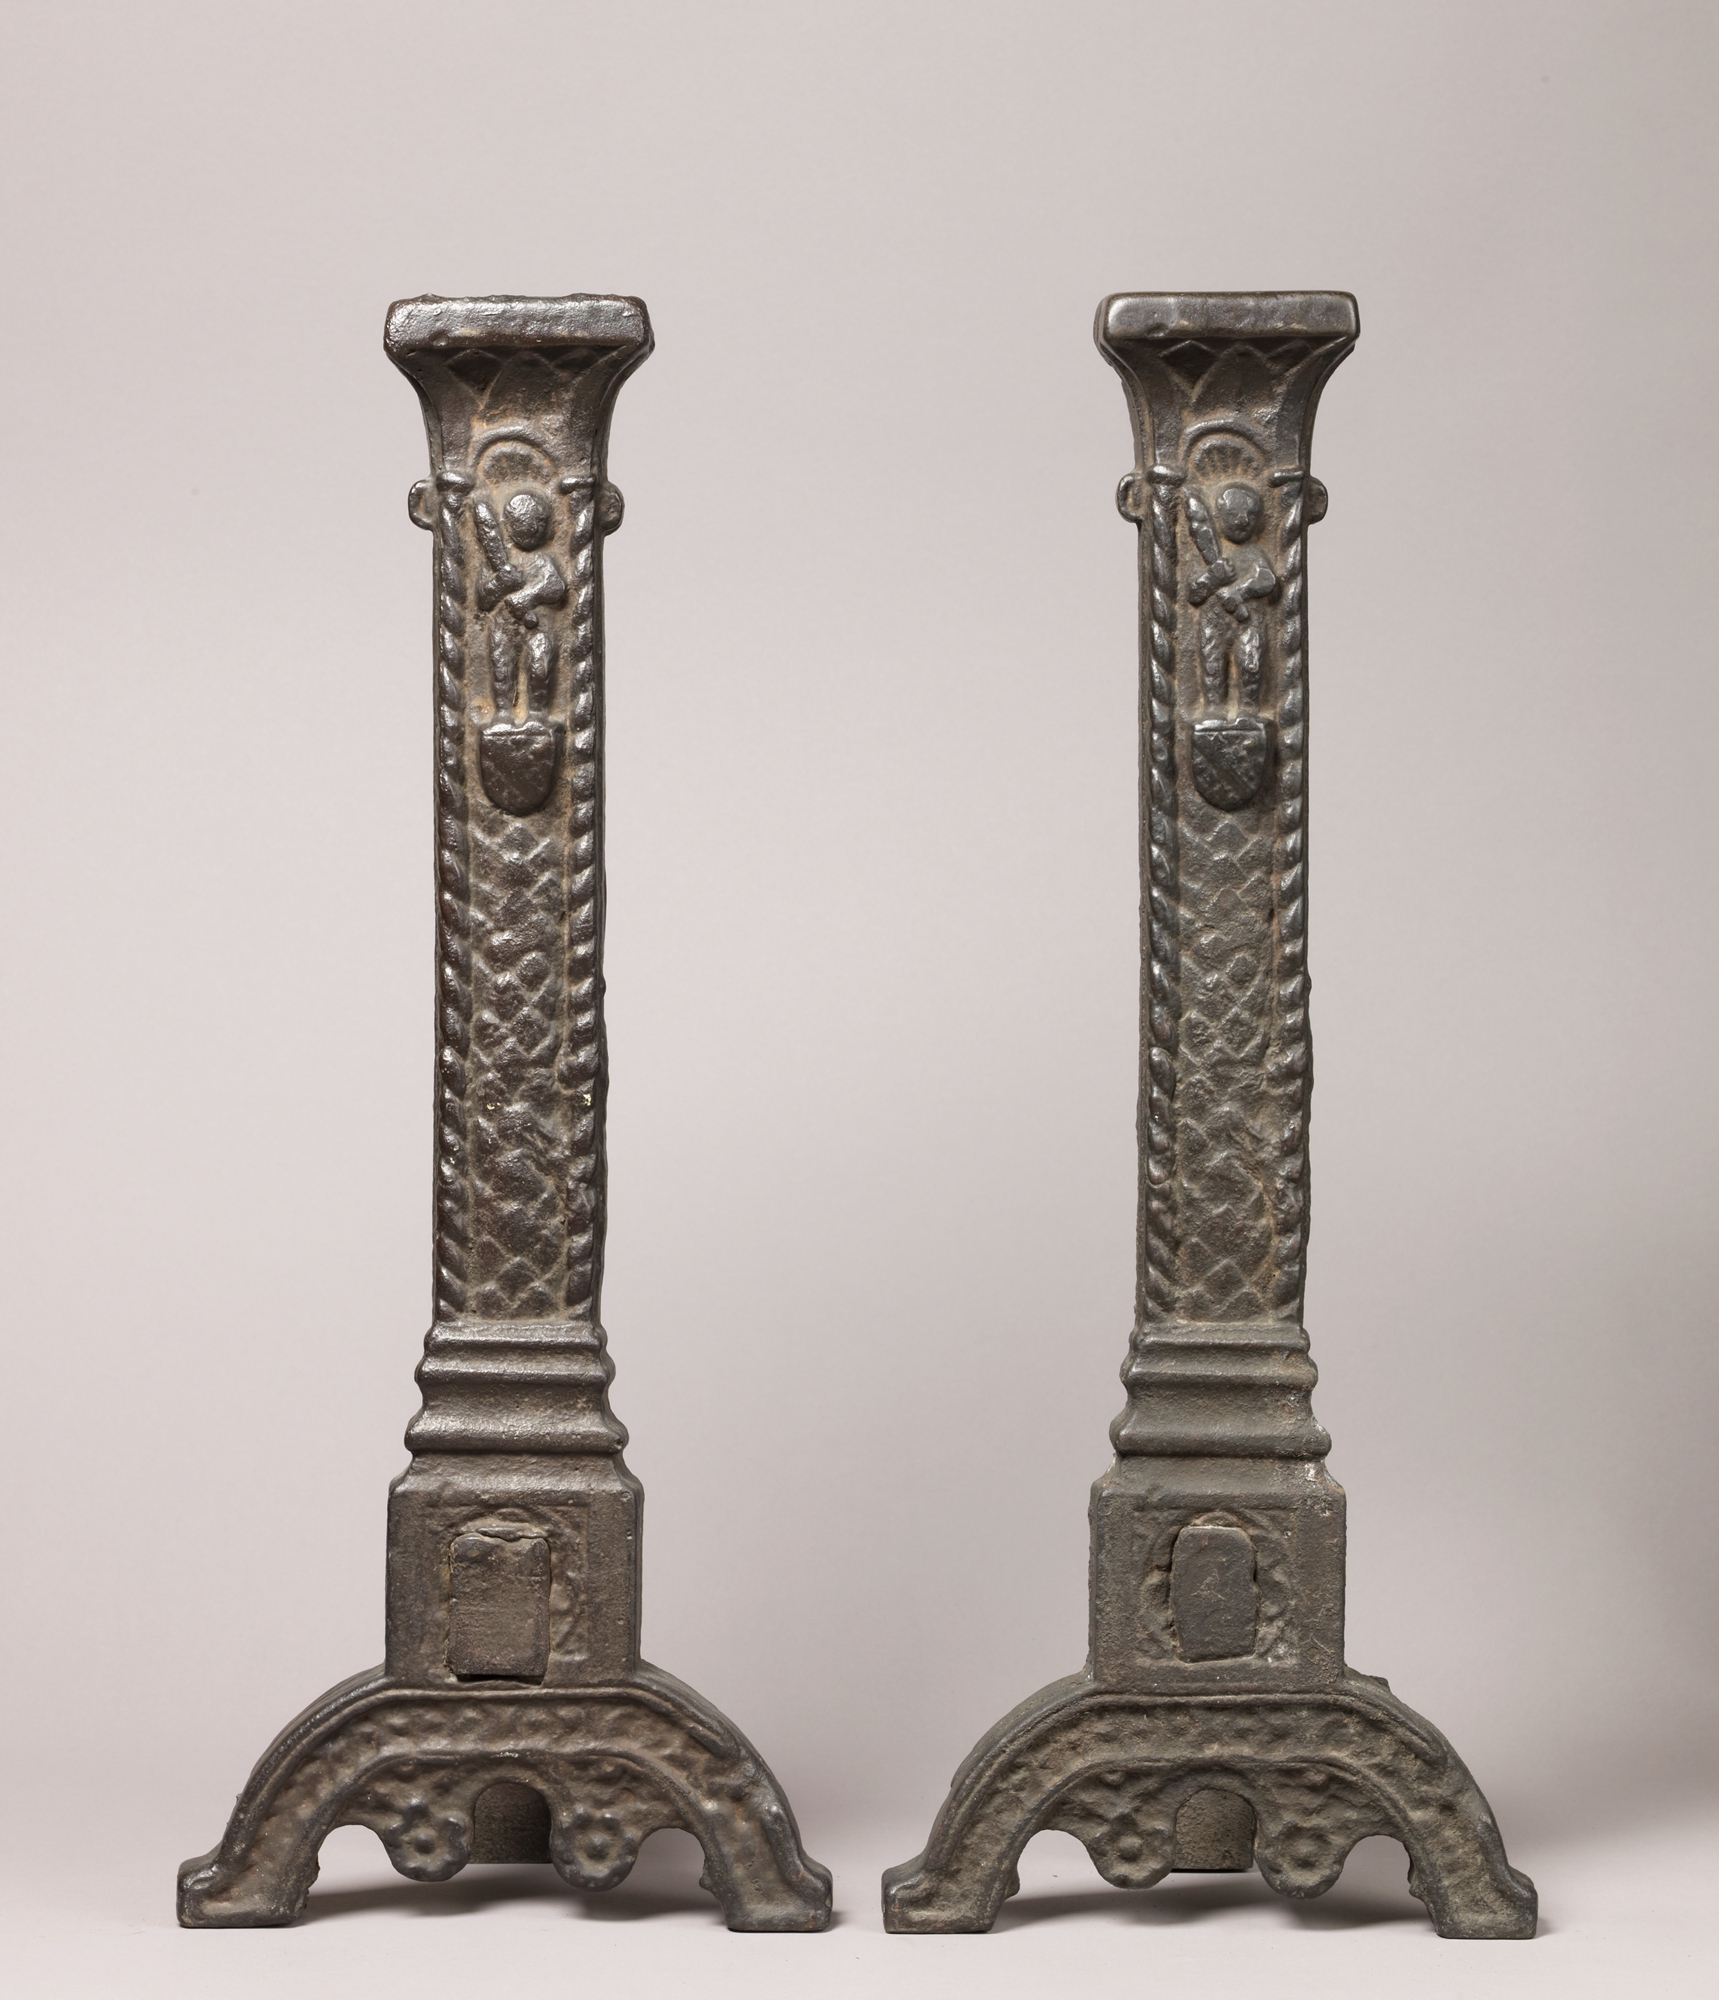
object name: firedog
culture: french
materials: iron